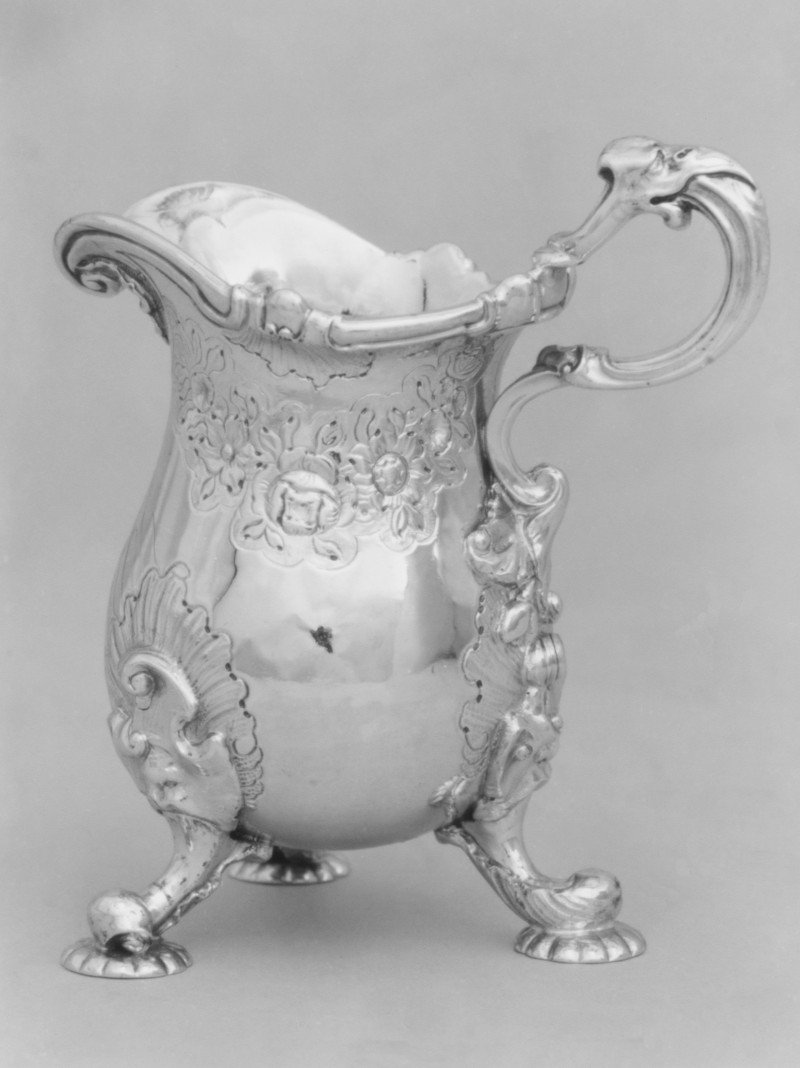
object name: cream jug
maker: paul de lamerie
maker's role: maker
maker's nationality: british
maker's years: 1688-1751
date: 1738-1739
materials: silver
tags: flowers